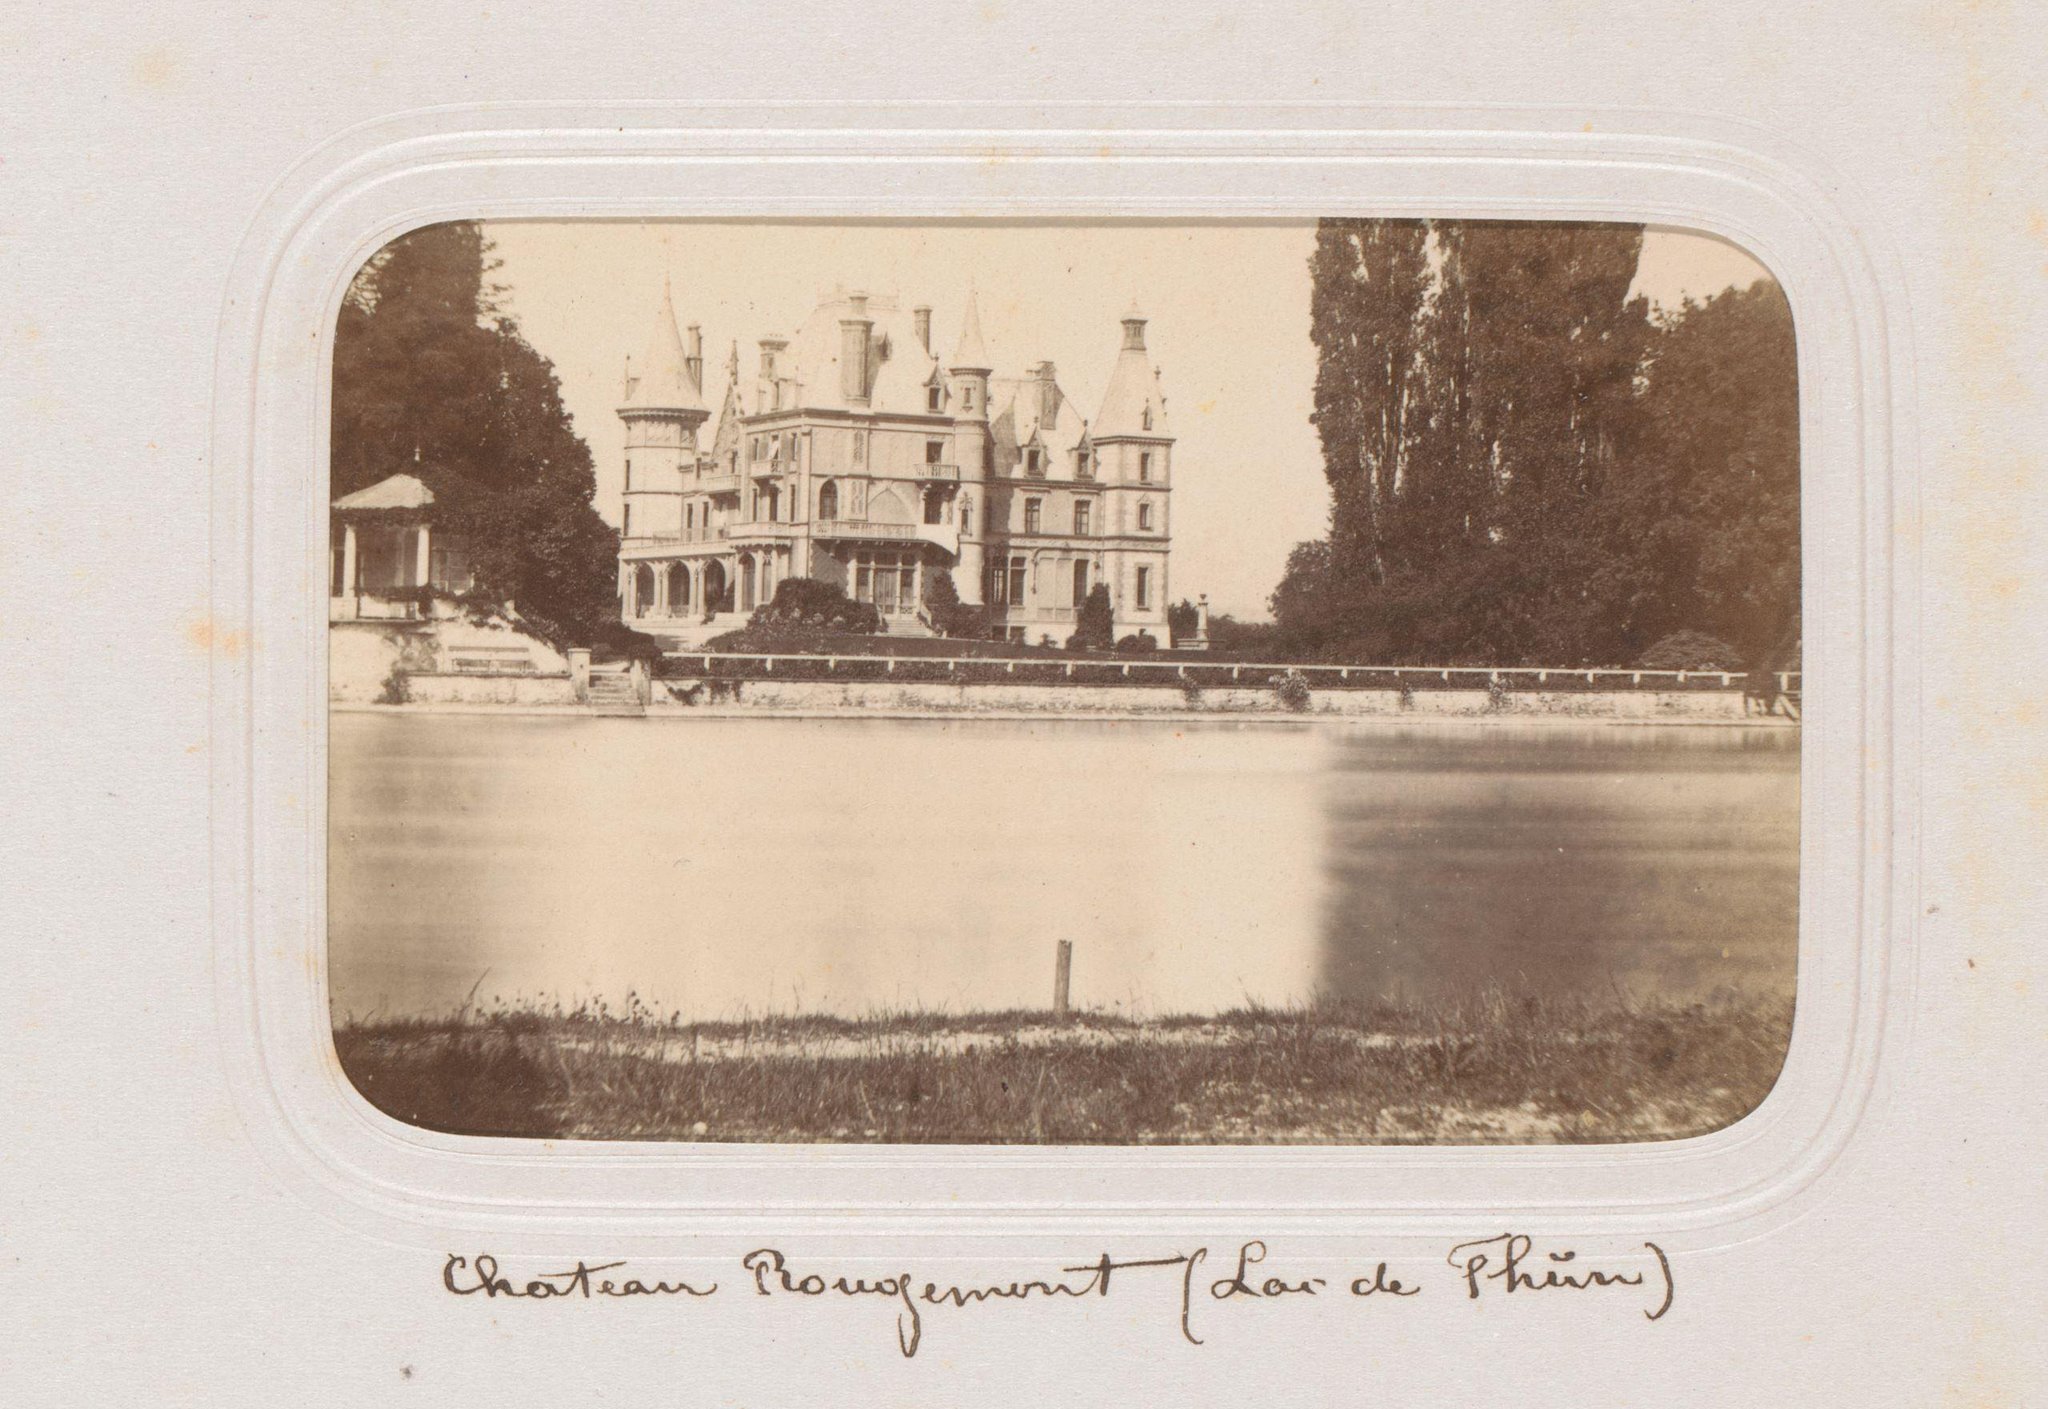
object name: carte de visite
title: Gezicht op Schloss Schadau aan het Meer van Thun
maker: florentin charnaux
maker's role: publisher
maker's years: 1819-1883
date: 1871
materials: cardboard, paper, photographic support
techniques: albumen print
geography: thuner see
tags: castle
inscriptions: number: ‘172’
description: Onderdeel van Reisalbum met foto's van bezienswaardigheden in Zwitserland.